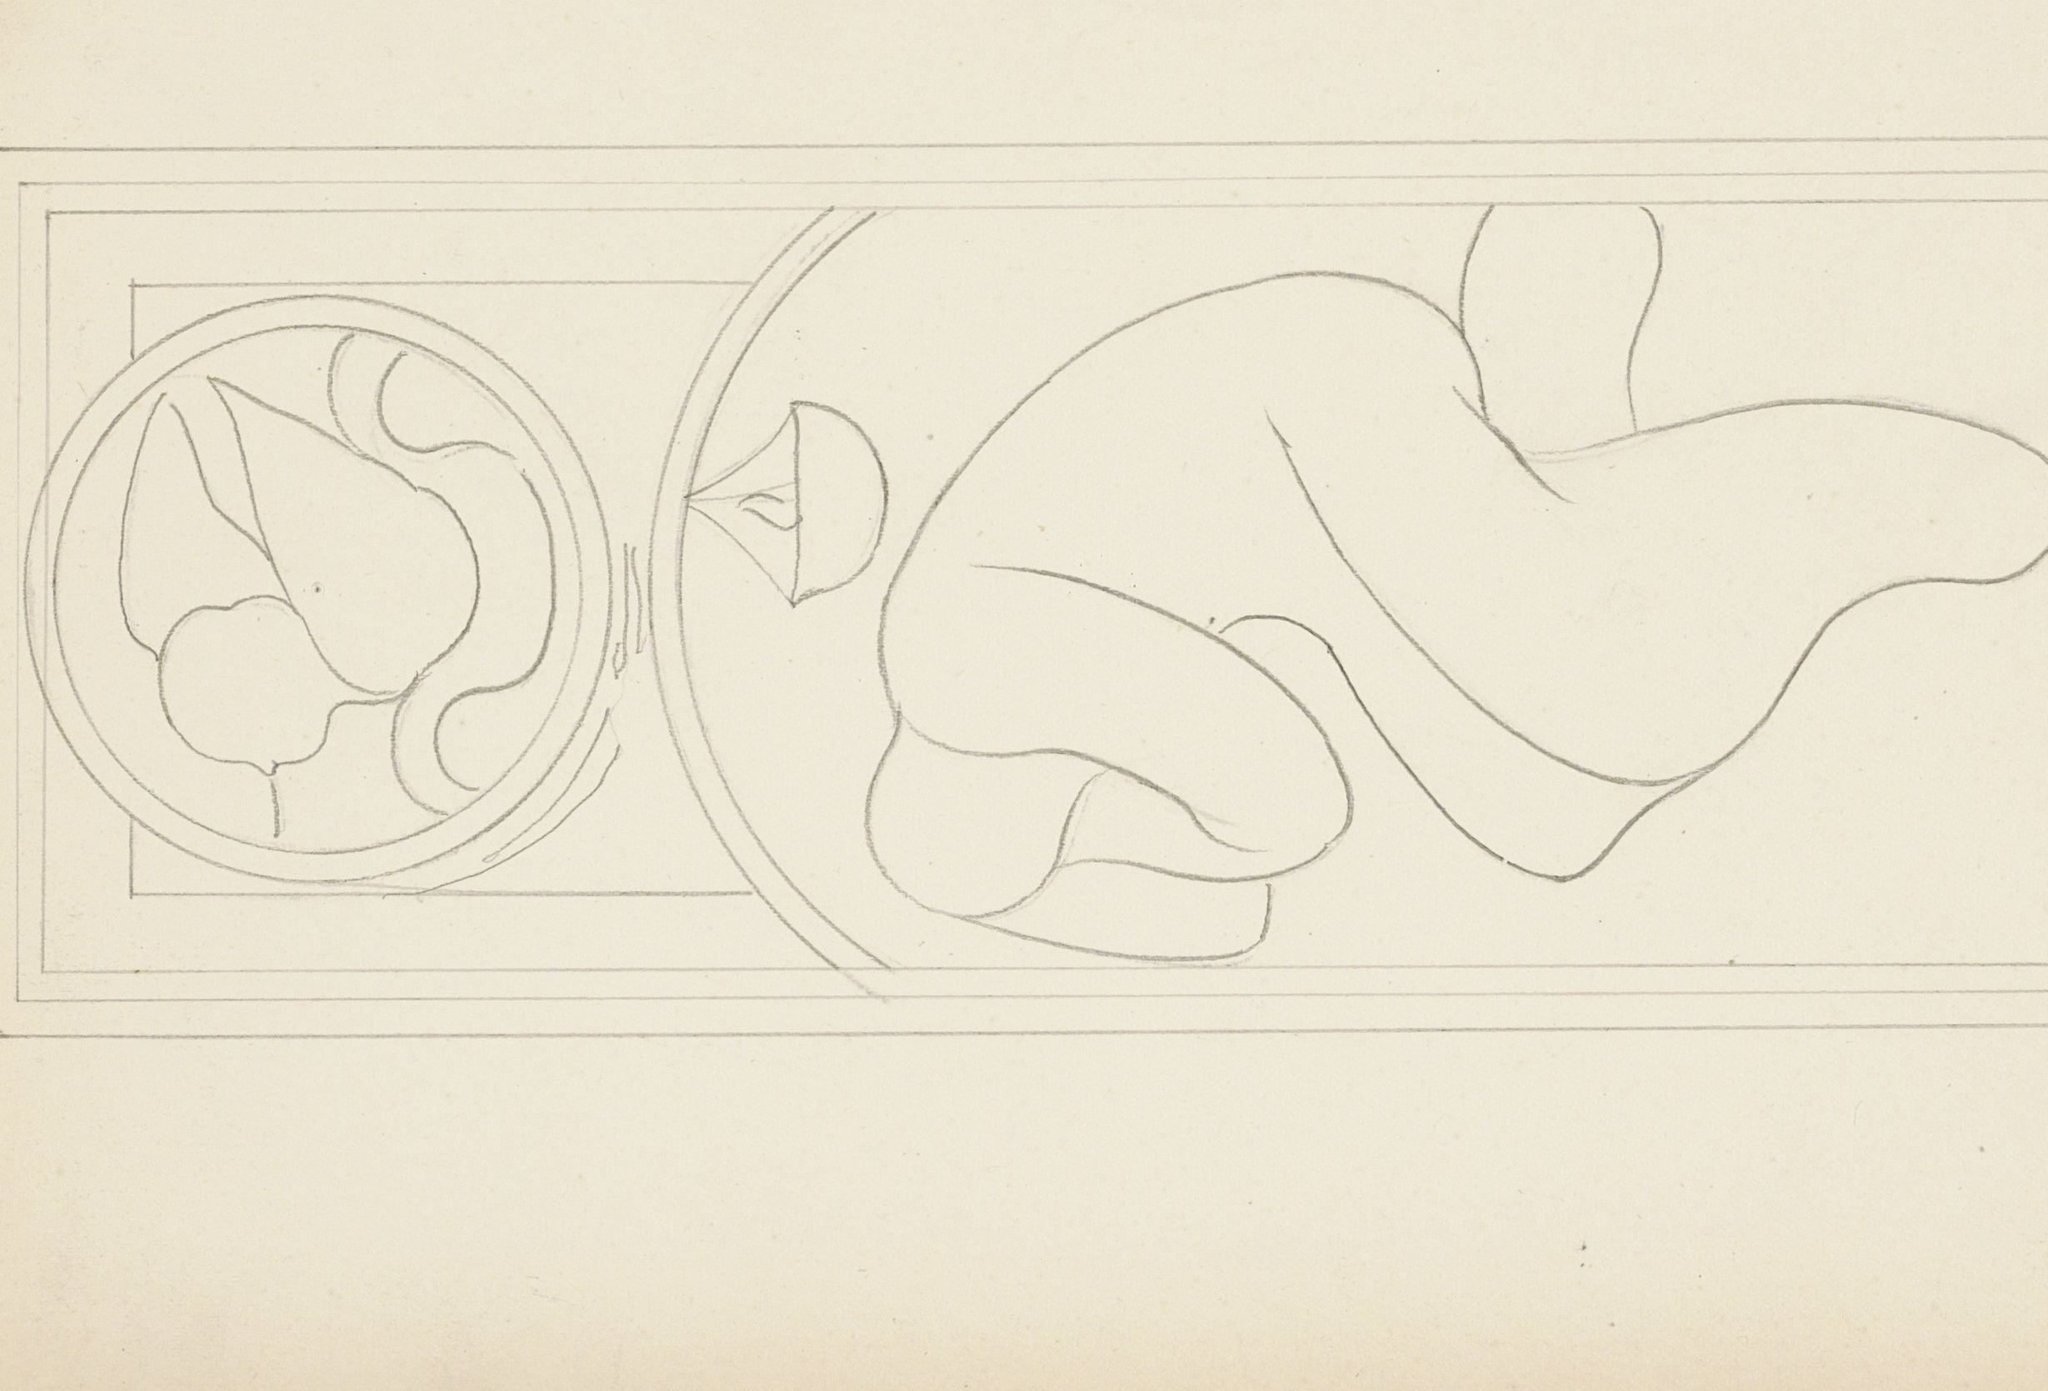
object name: sketchbook leaf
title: Ontwerp voor een venster met slapende figuur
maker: antoon derkinderen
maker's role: draughtsman, painter, print maker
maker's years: 1859-1925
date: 1900-1903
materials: paper, pencil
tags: window, sleeping; unconsciousness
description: De figuur zit ineengedoken met het hoofd rustend op de armen. Mogelijk Hypnos, de personificatie van de slaap. Boven de figuur een putto in een medaillon. Ontwerp voor een glas-in-loodraam voor de Kamer van Koophandel in de Beurs van Berlage te Amsterdam. Blad 24 recto uit een schetsboek met 45 bladen.